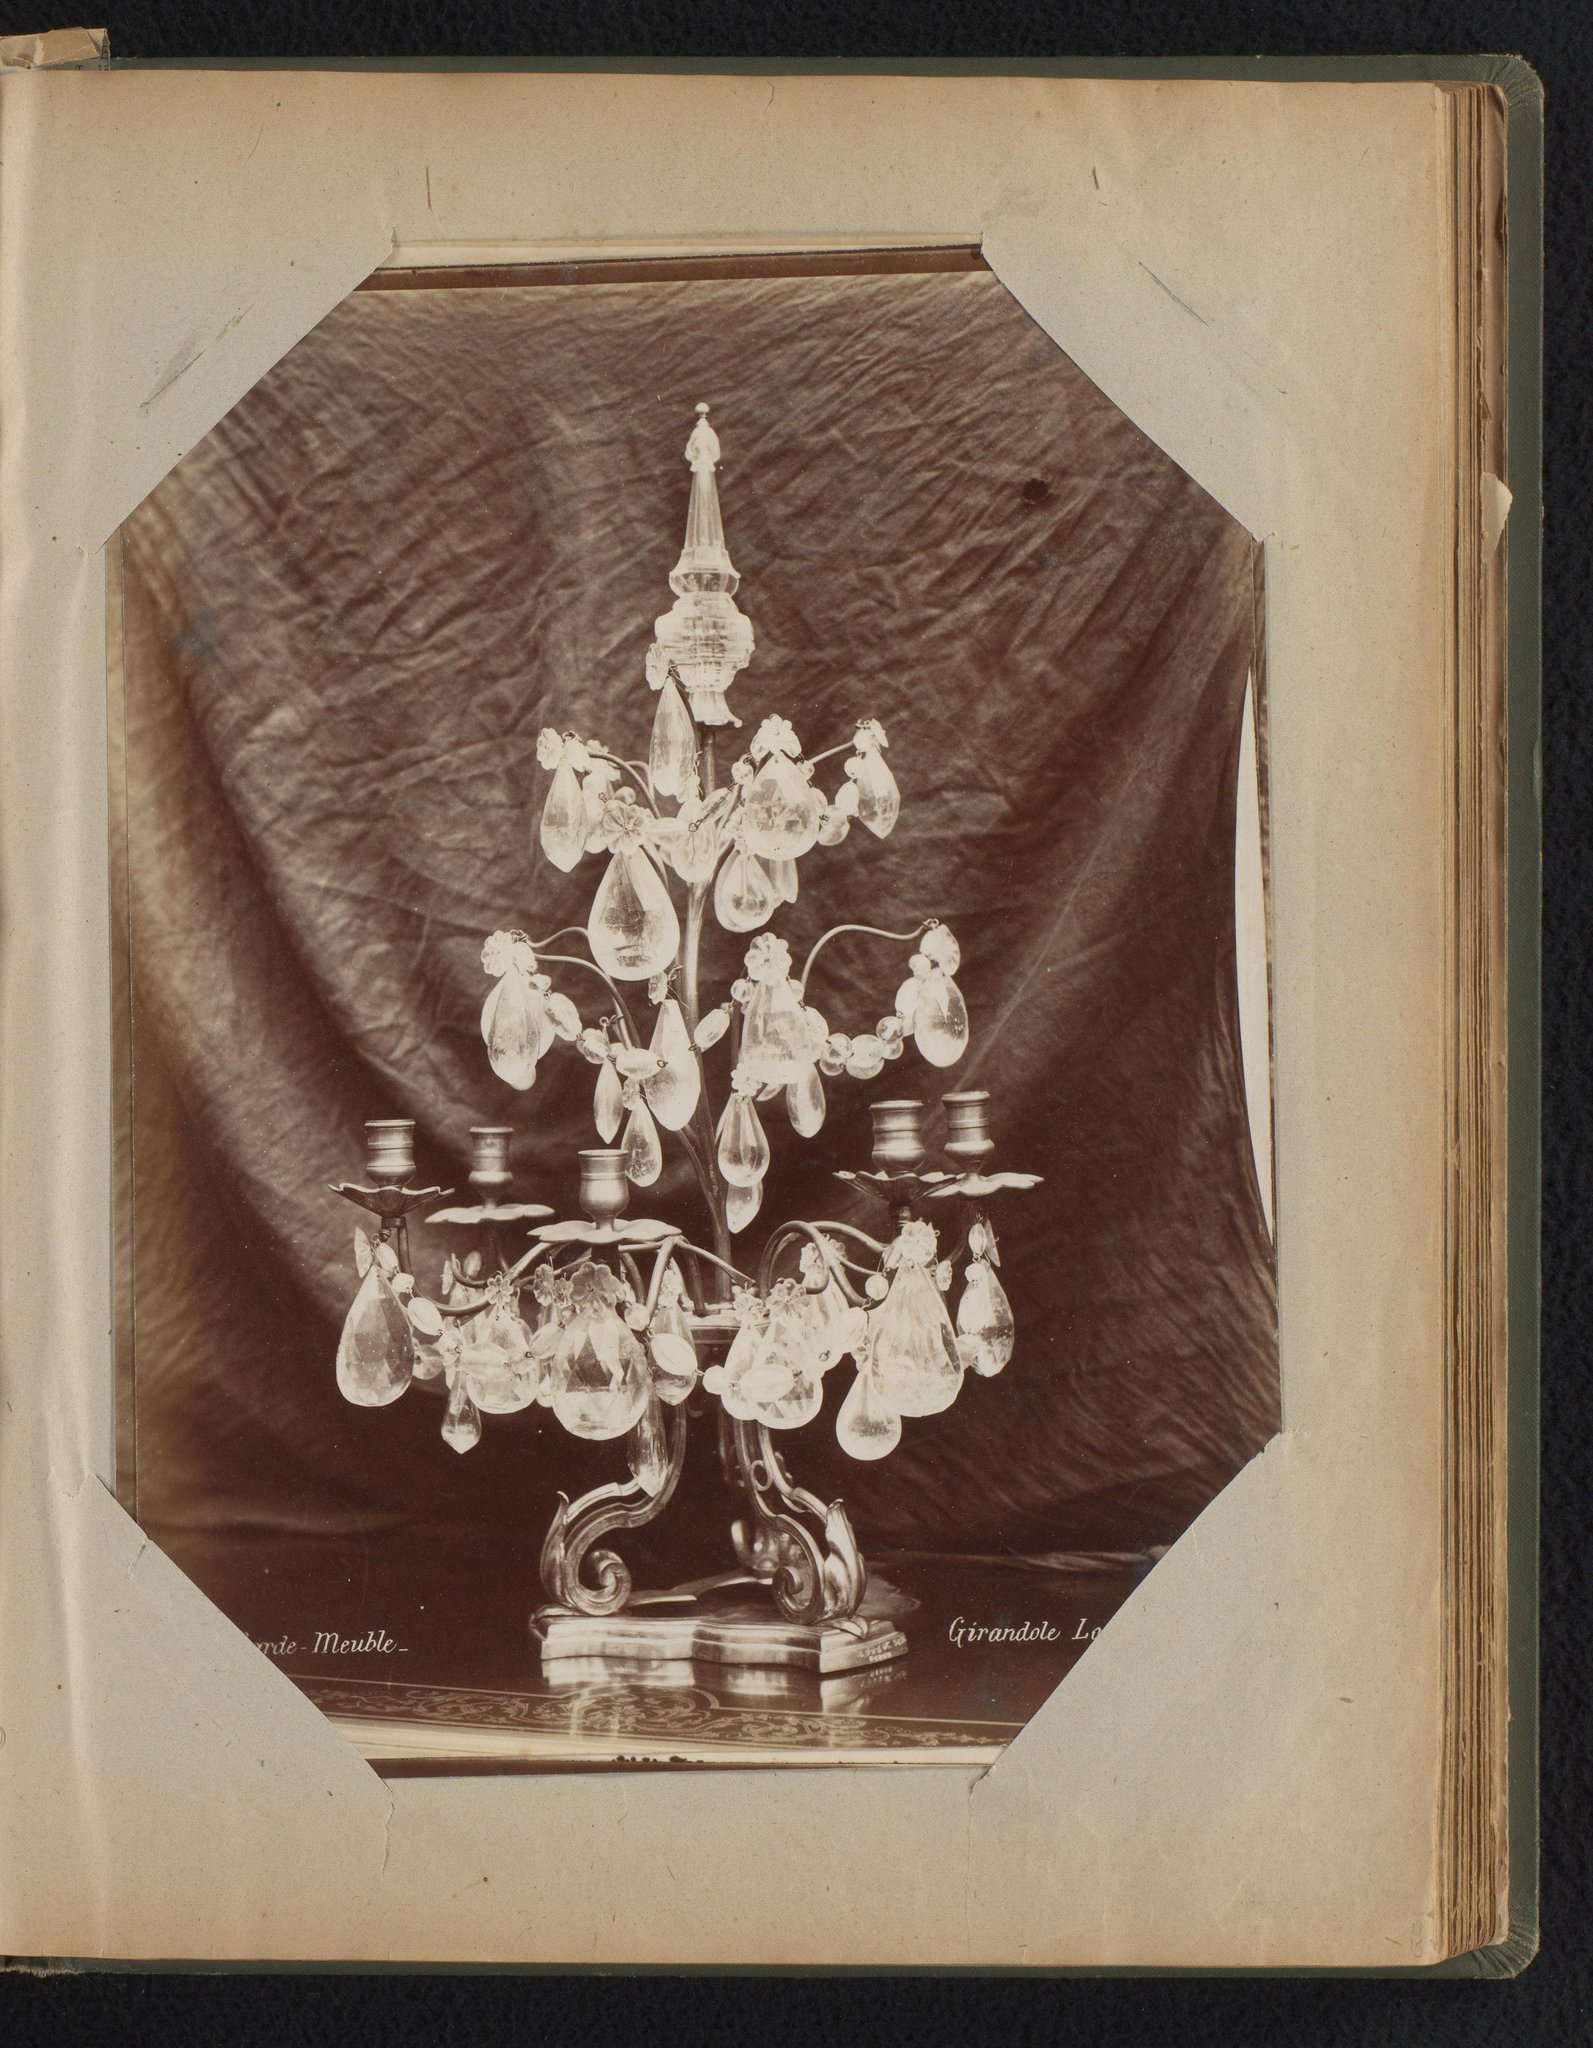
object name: photograph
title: Kandelaar met kristallen ornamenten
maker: Anonymous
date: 1860-1900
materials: canvas, cardboard, paper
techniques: matte daylight collodion silver print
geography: netherlands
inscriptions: annotation: ‘... Candelabre Louis XV - J.D.’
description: Foto maakt deel uit van een album met een serie met betrekking tot het interieur van het paleis van Versailles met kroonluchters, deuren, portalen en meubelstukken. Achter deze foto zit RP-F-2005-46-11 gestoken.